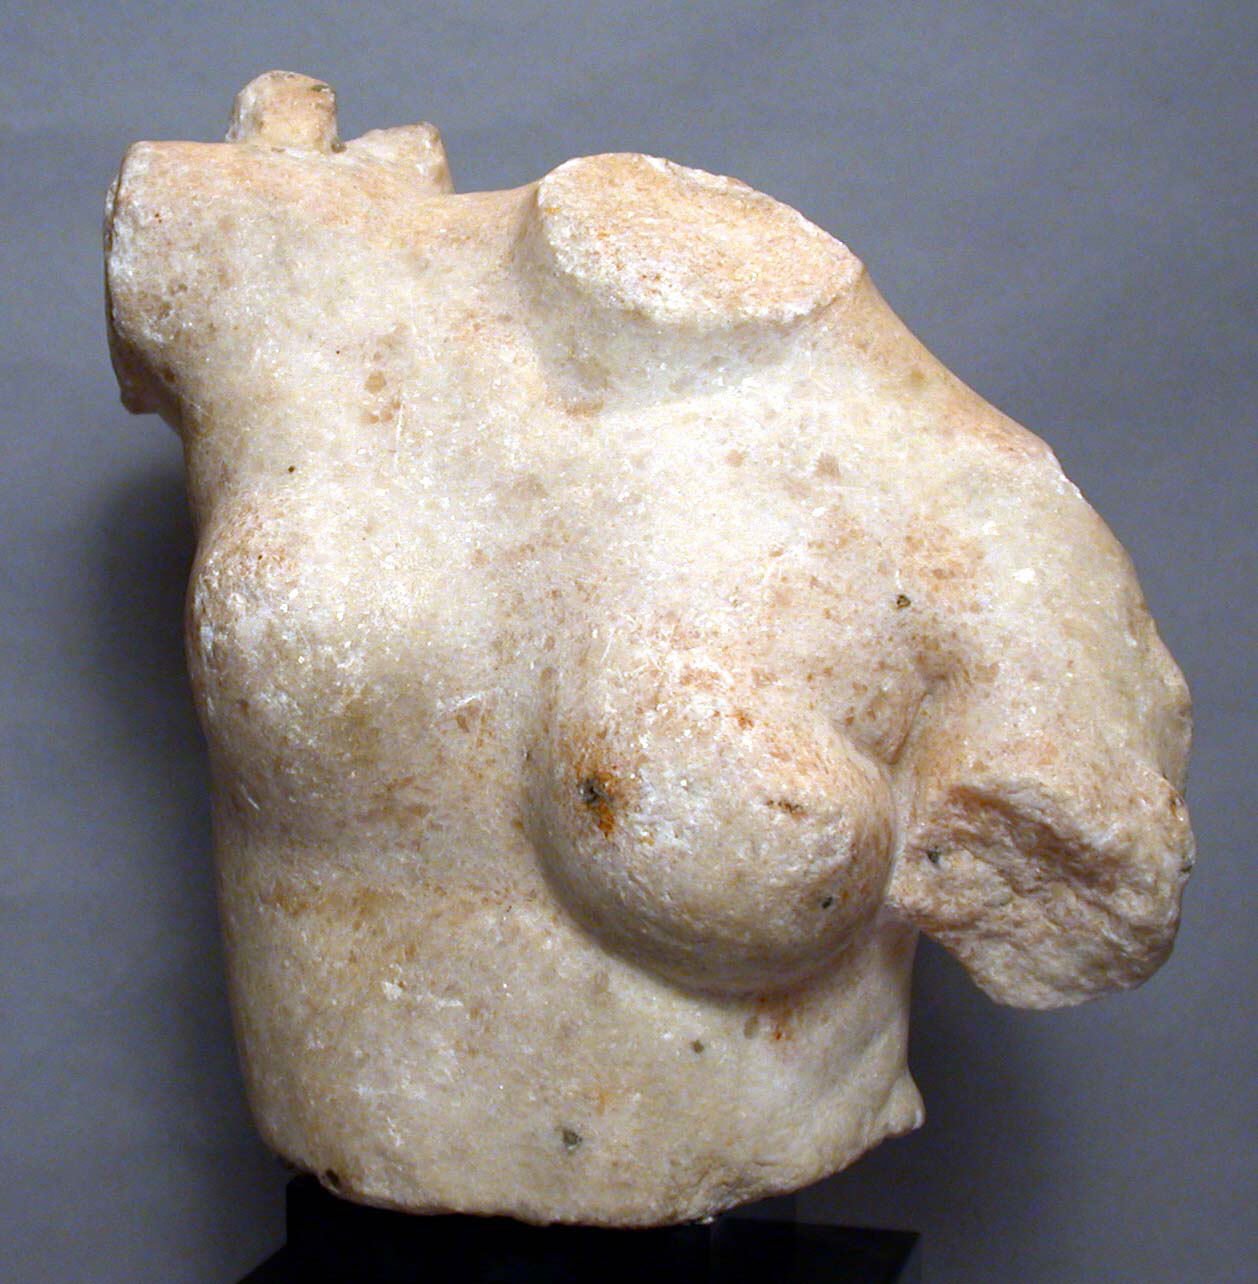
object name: torso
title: Marble torso of Aphrodite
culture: greek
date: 1-200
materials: marble